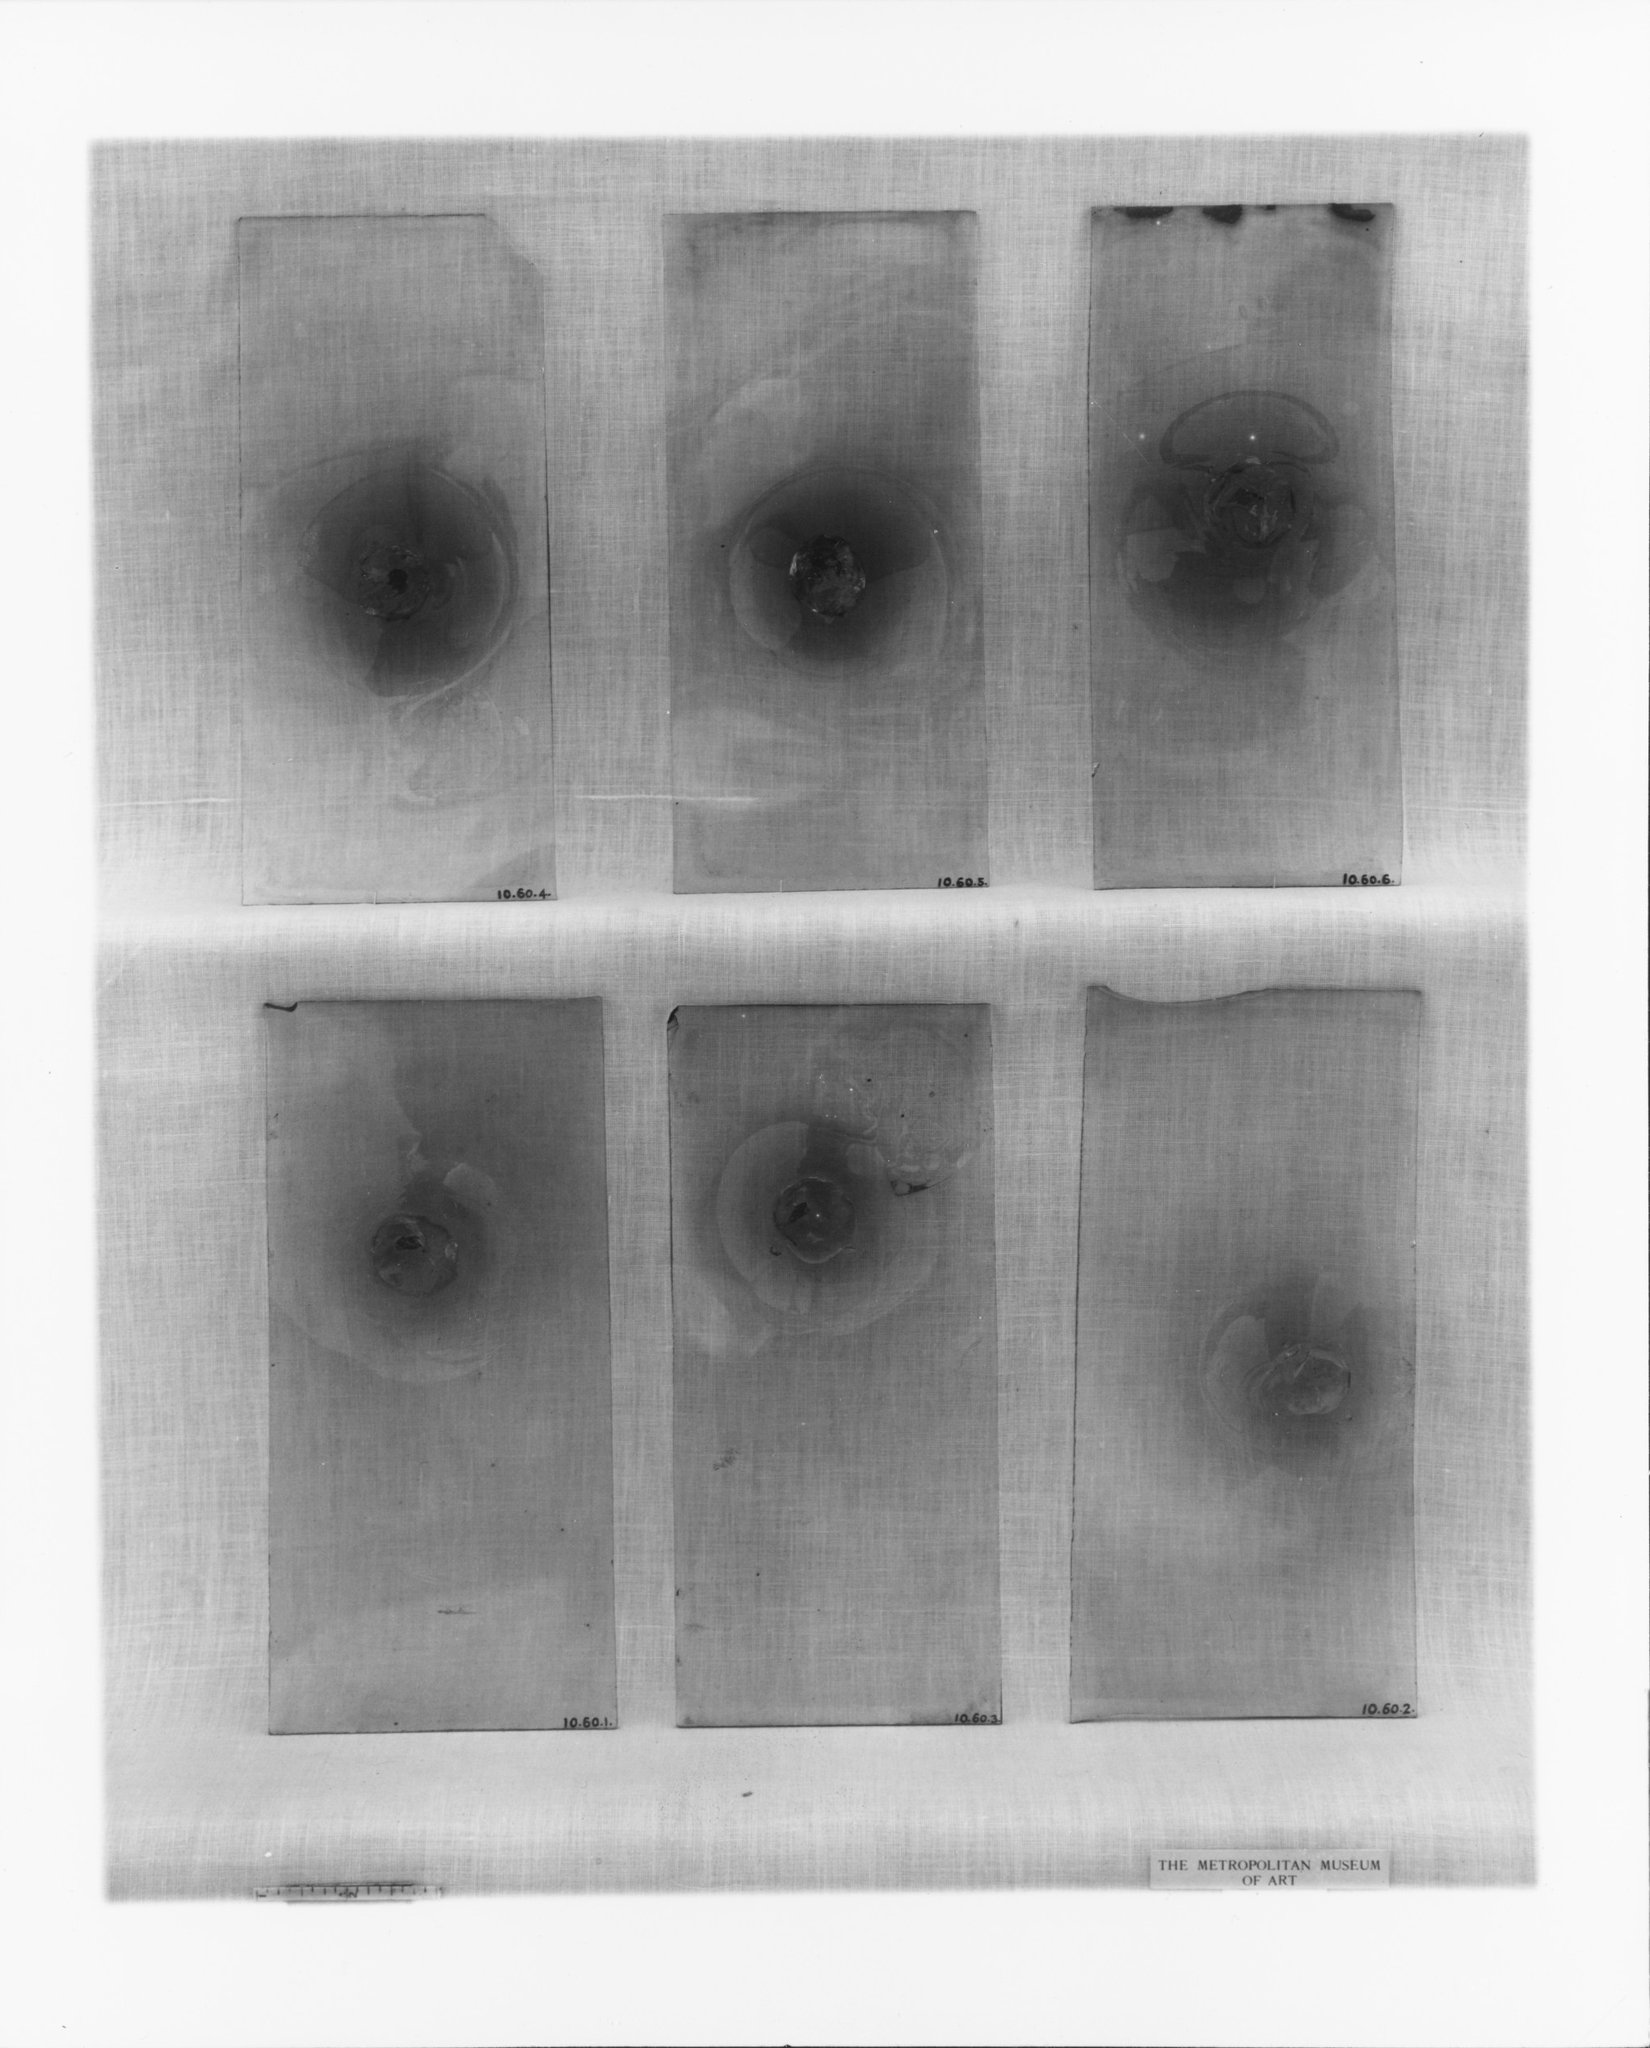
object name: windowpane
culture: american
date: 1701-1800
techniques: glassblowing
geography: united states